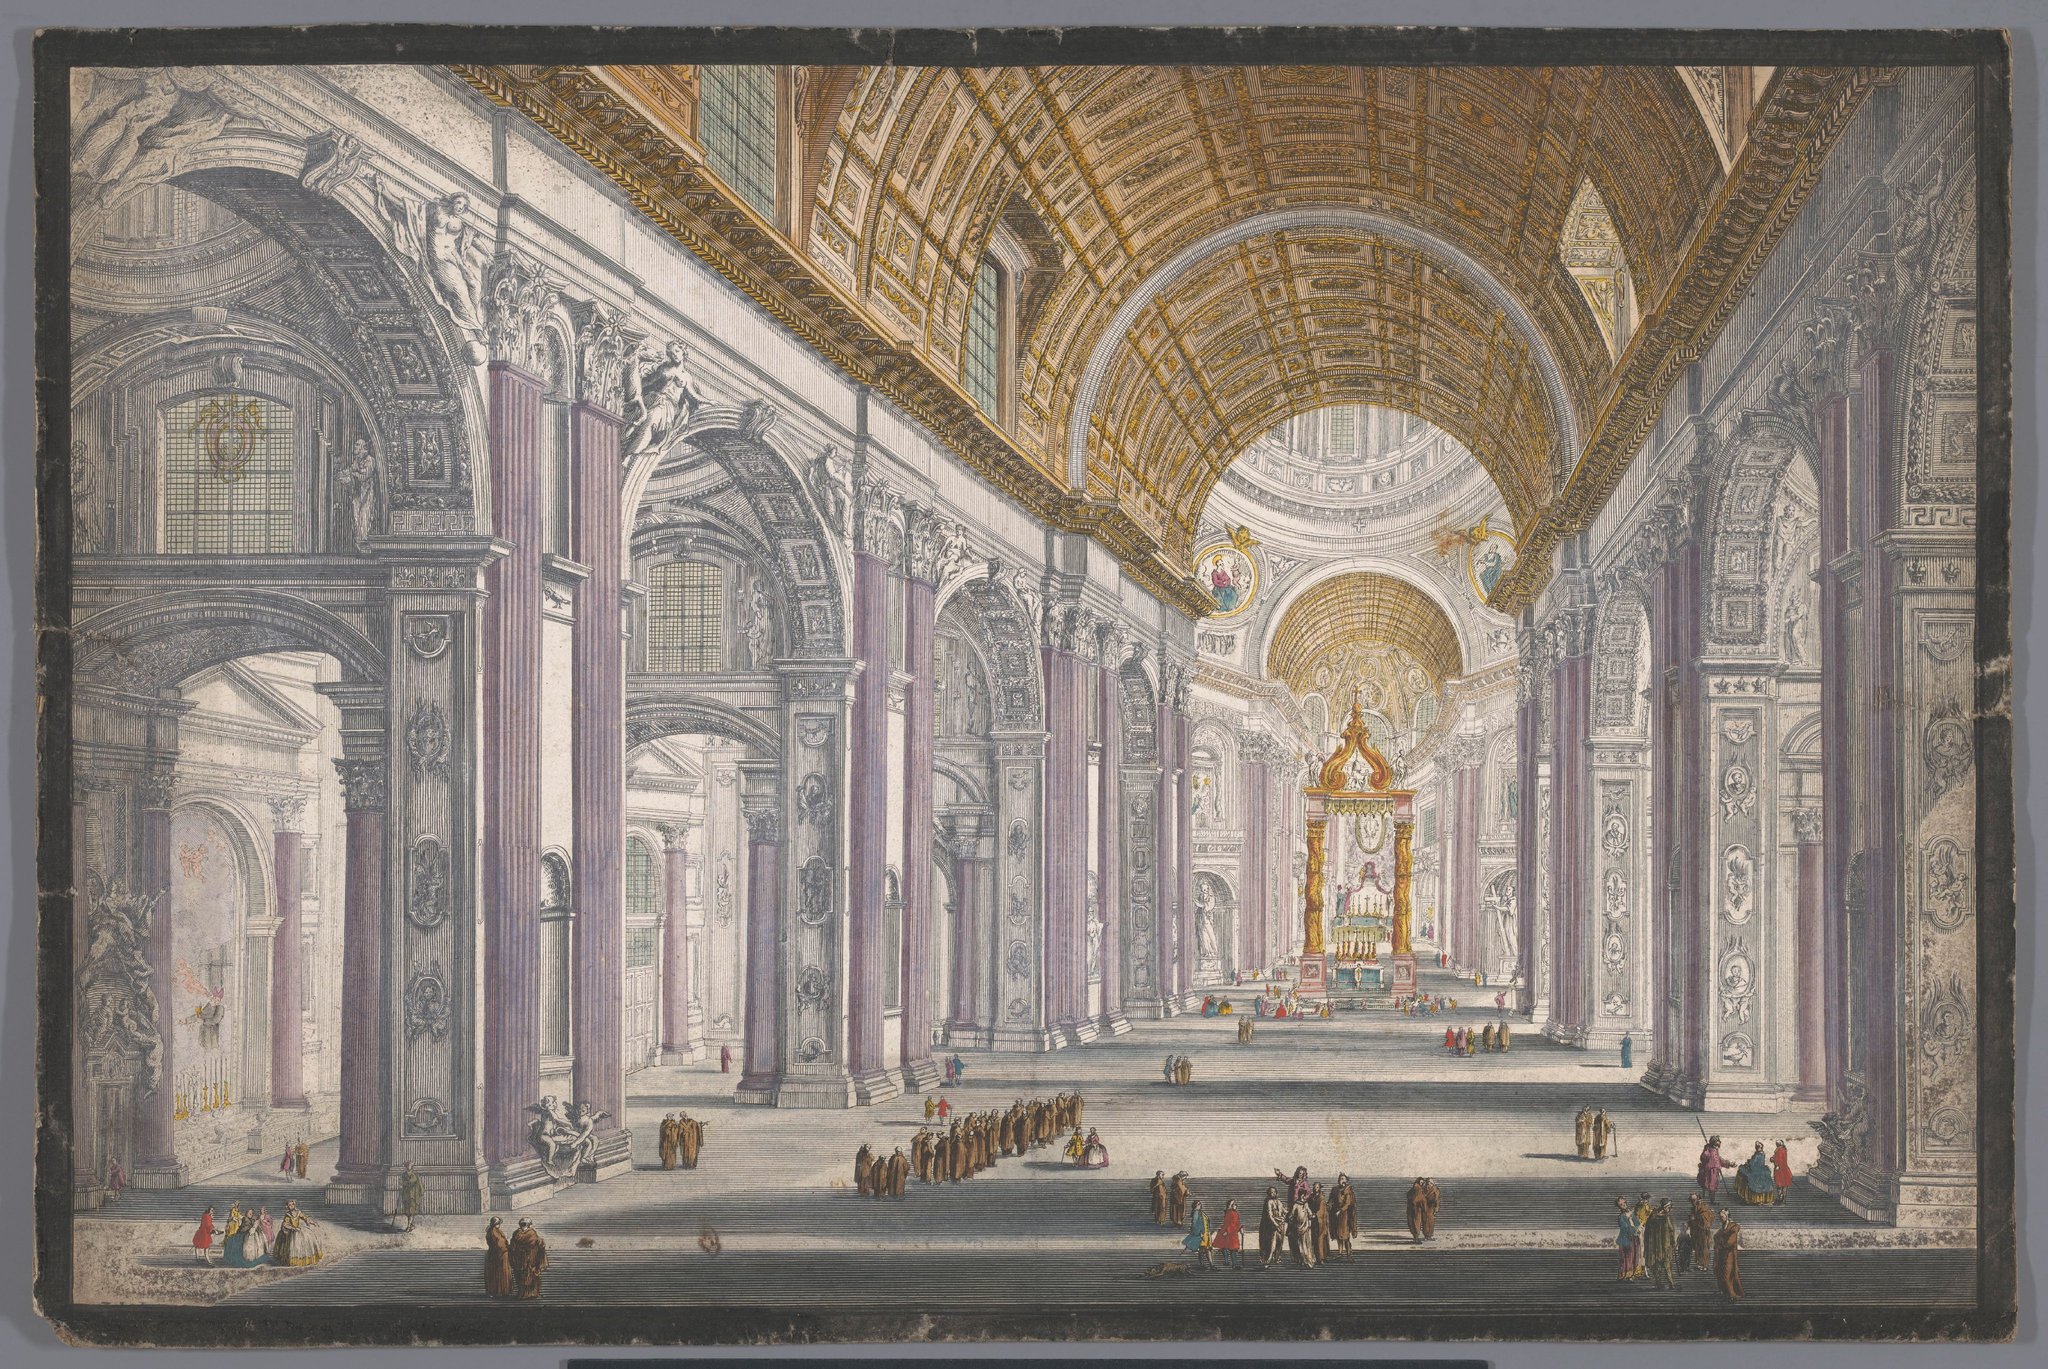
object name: print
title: Veduta interna della Basilica di S. Pietro in Vaticano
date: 1700-1799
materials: cardboard, paper, watercolor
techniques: brush, etching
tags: interior of church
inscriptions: collector's mark: Lugt 2233